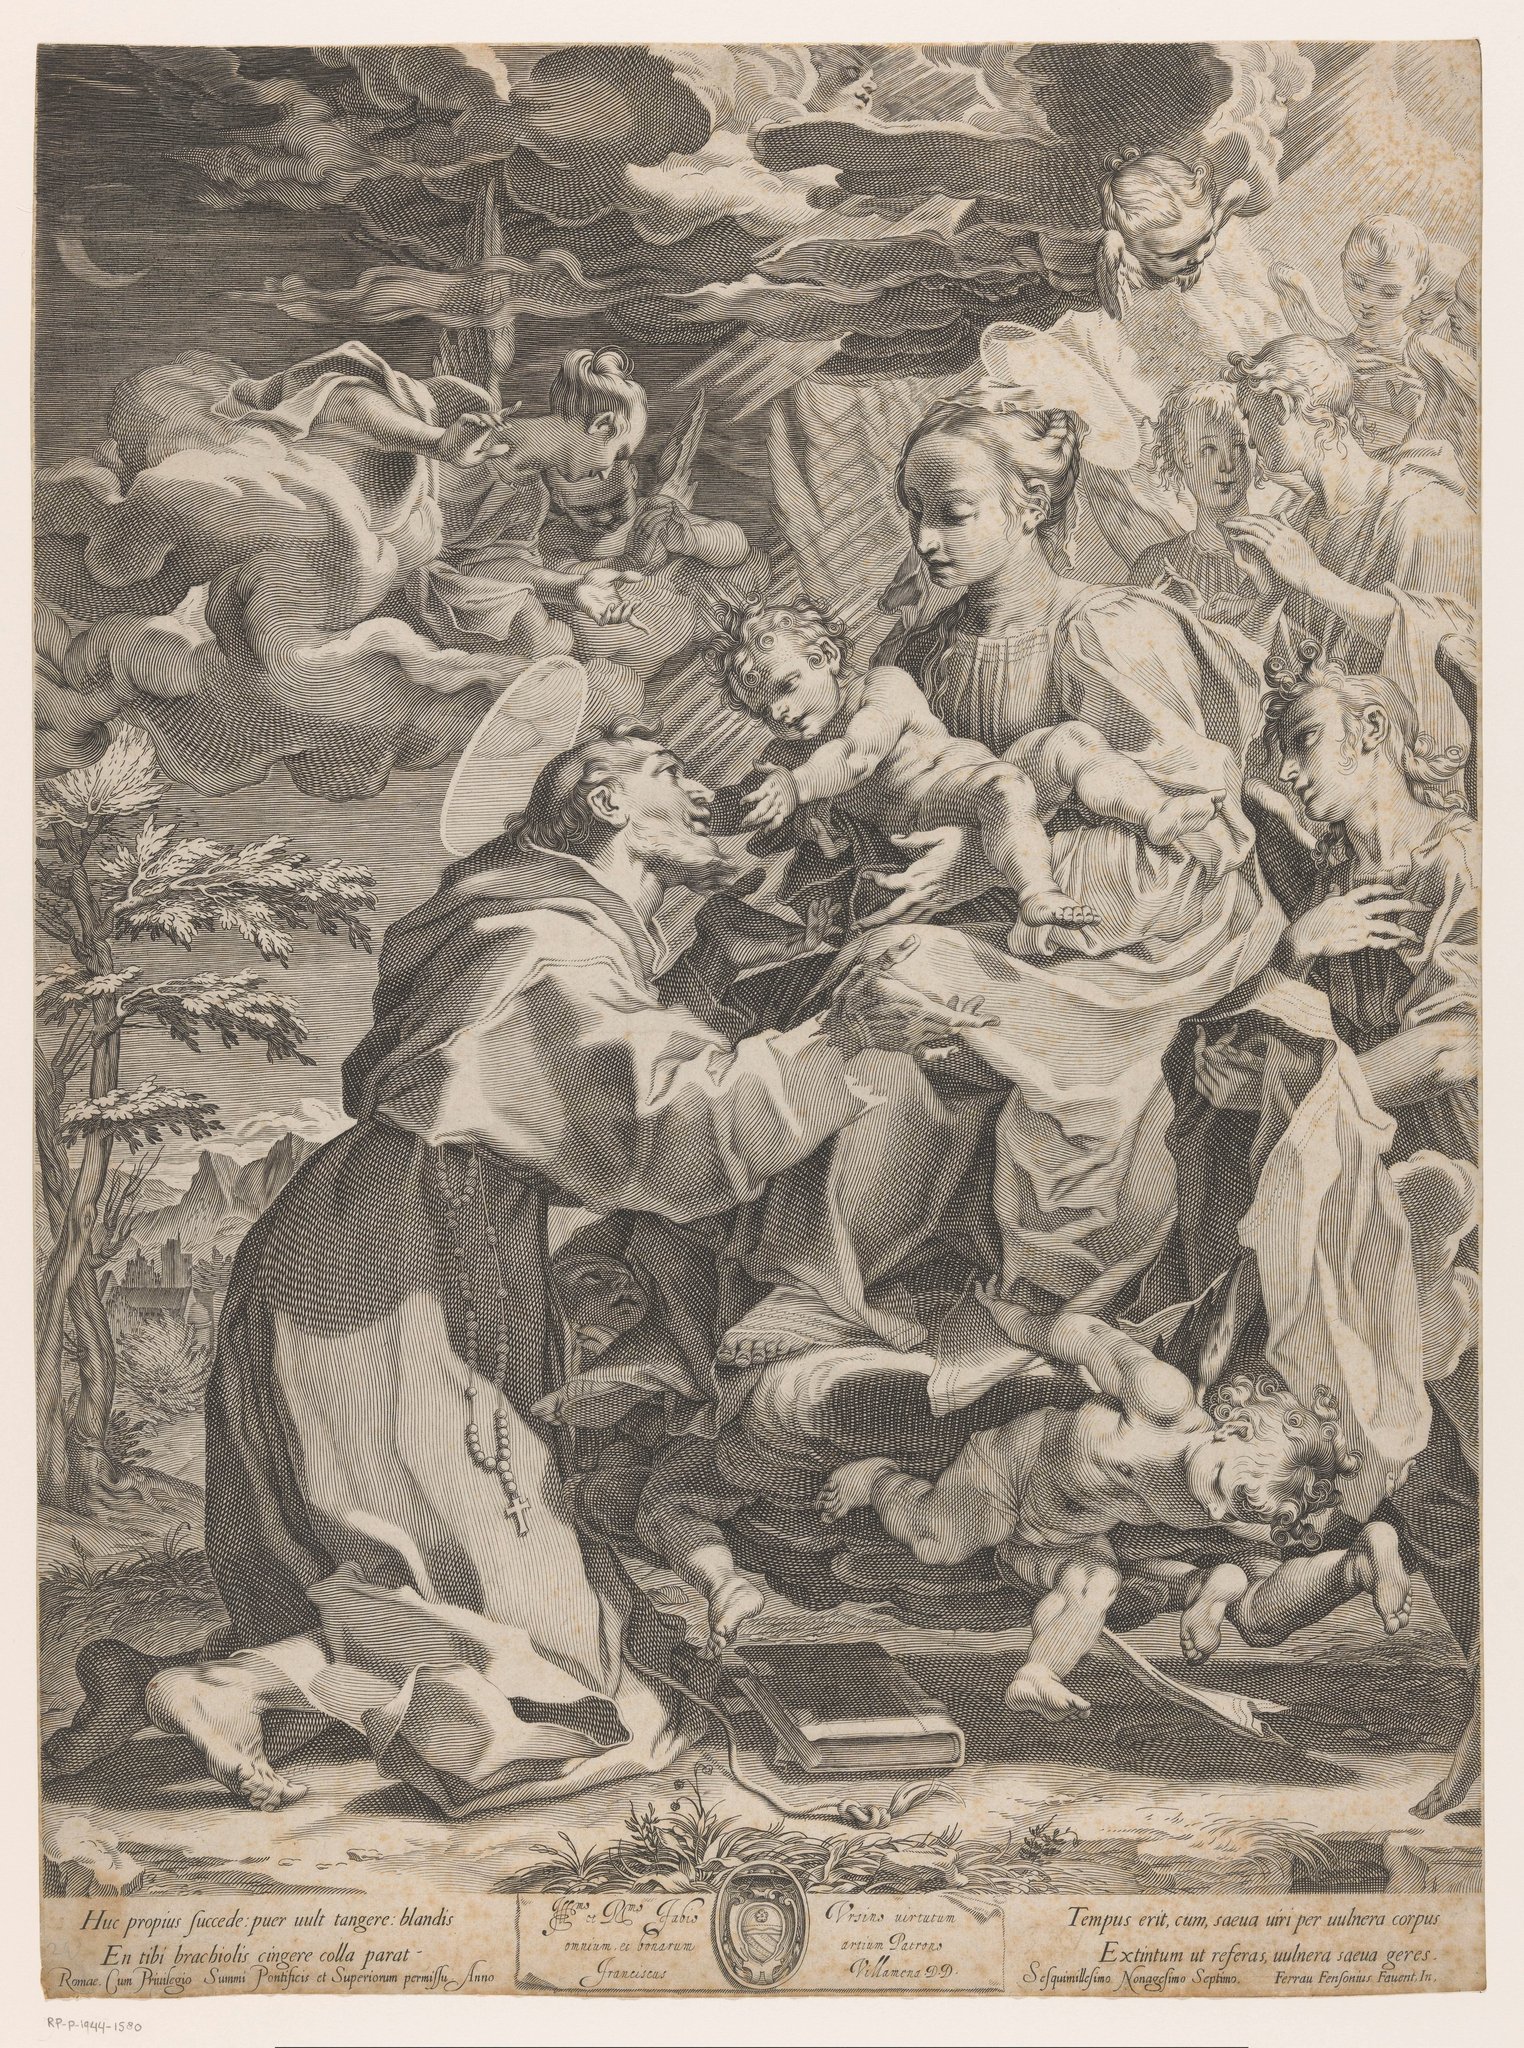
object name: print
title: Maria overhandigt het Christuskind aan Franciscus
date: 1597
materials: paper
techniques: engraving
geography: italy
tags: cherubs, i.e. children's heads with wings, angels, the virgin mary handing over the infant christ to st. francis of assisi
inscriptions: collector's mark: Lugt 2228, collector's mark: Lugt 240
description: Te midden van engelen overhandigt Maria het Christuskind aan de knielende heilige Franciscus van Assisi. Op de grond ligt een boek. Opdracht, wapenschild en Latijnse tekst in twee kolommen in ondermarge.